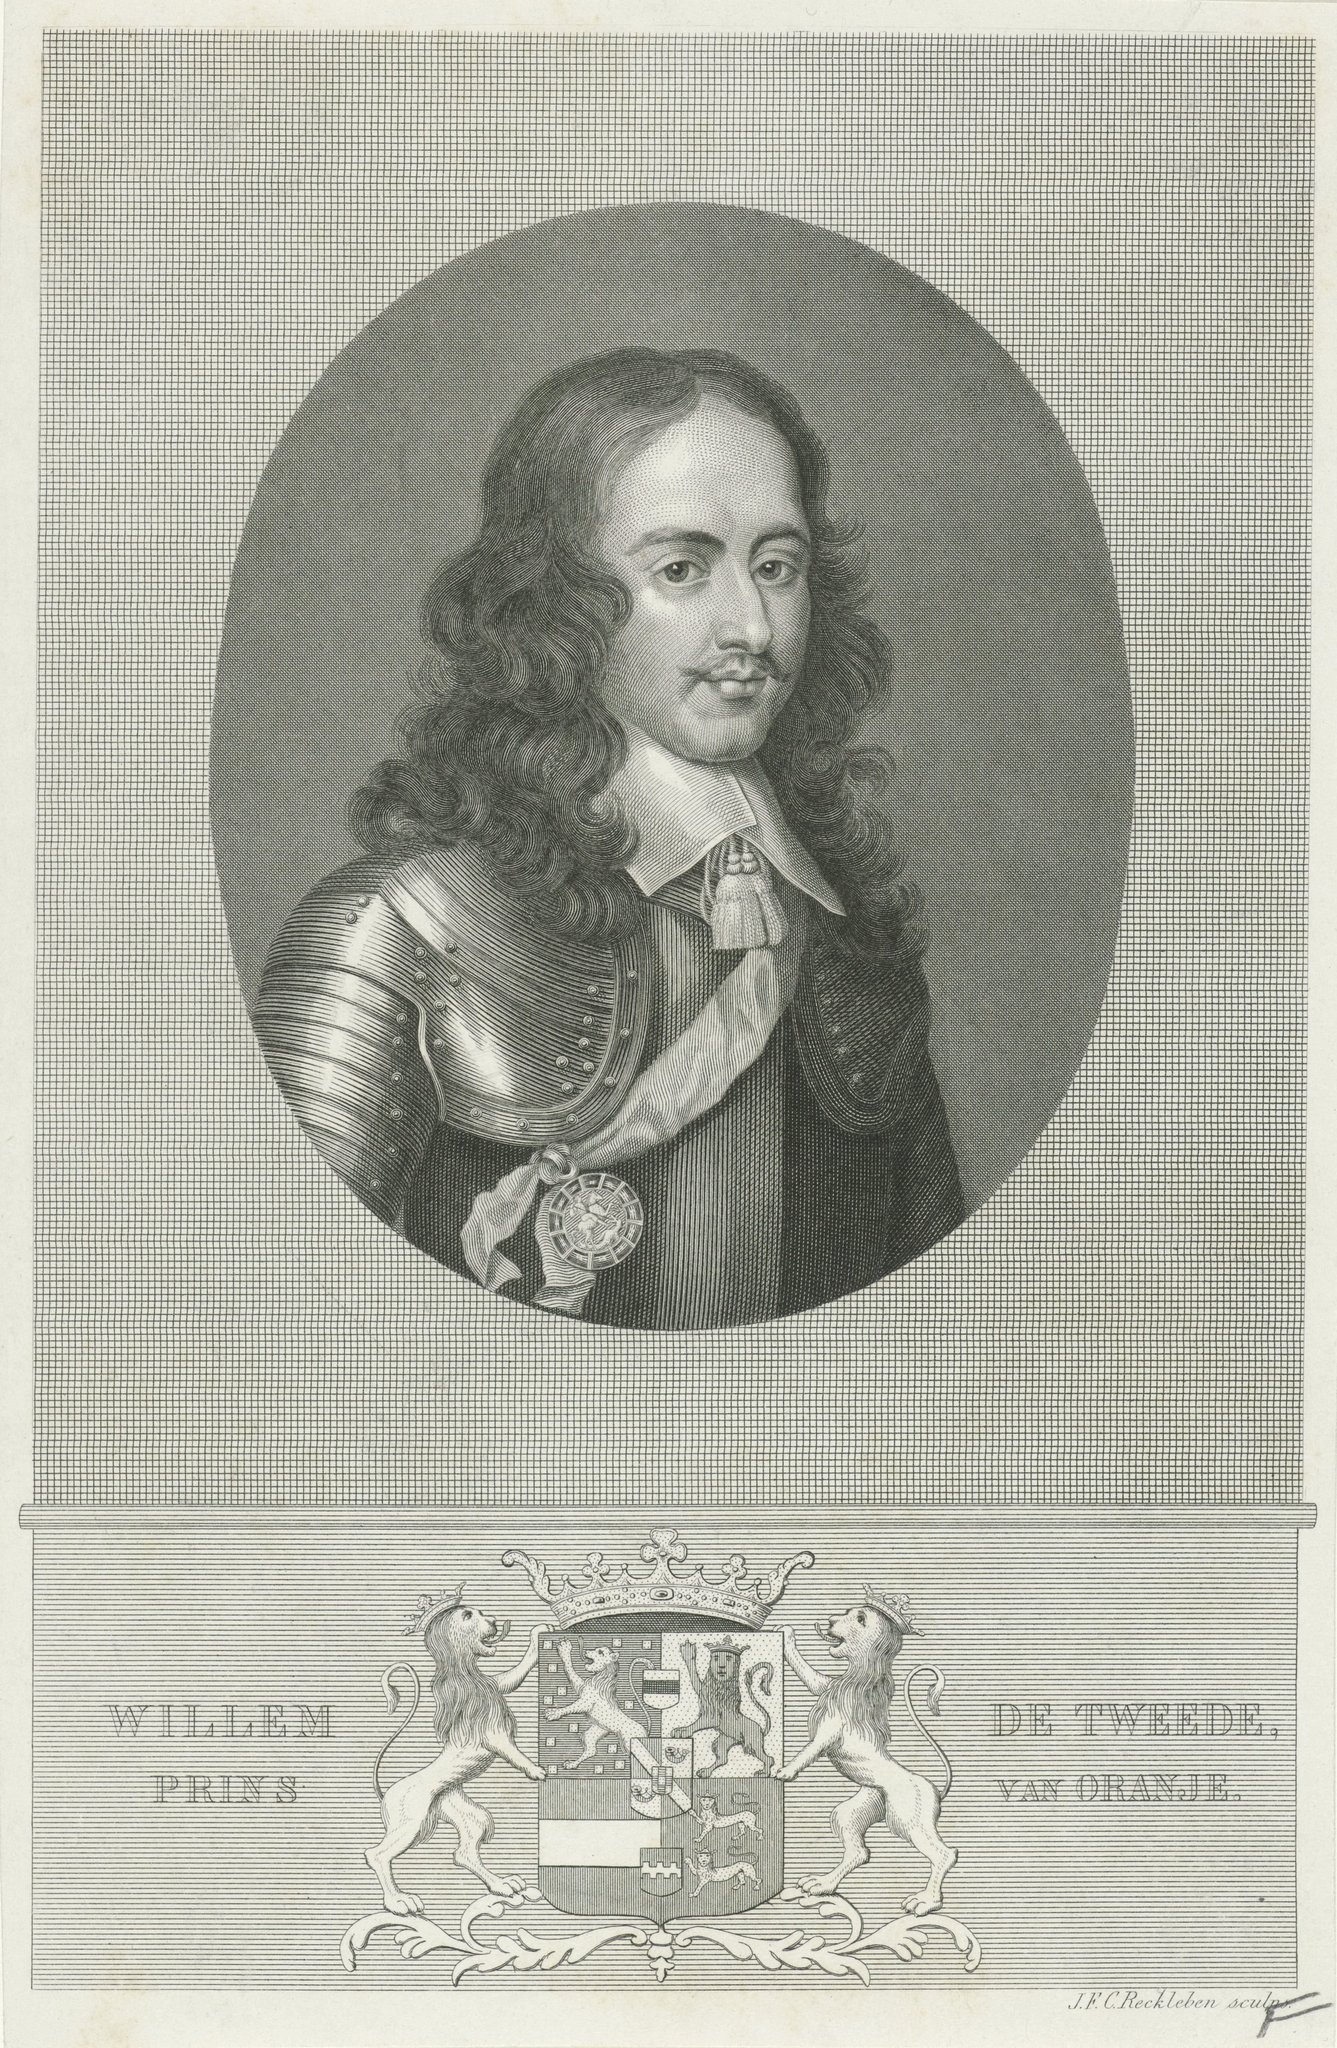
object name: print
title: Portret van Willem II, prins van Oranje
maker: jan frederik christiaan reckleben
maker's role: print maker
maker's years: 1819-1879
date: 1866-1868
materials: paper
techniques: engraving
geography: amsterdam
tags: william ii (prince of orange)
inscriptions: collector's mark: Lugt 2228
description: Illustratie in: Arend, Johannes Pieter. Algemeene geschiedenis des vaderlands van de vroegste tijden tot op heden. 5 delen, Amsterdam: Schleijer, J.F. 1840-1884, dl. 3.5, p. 433.